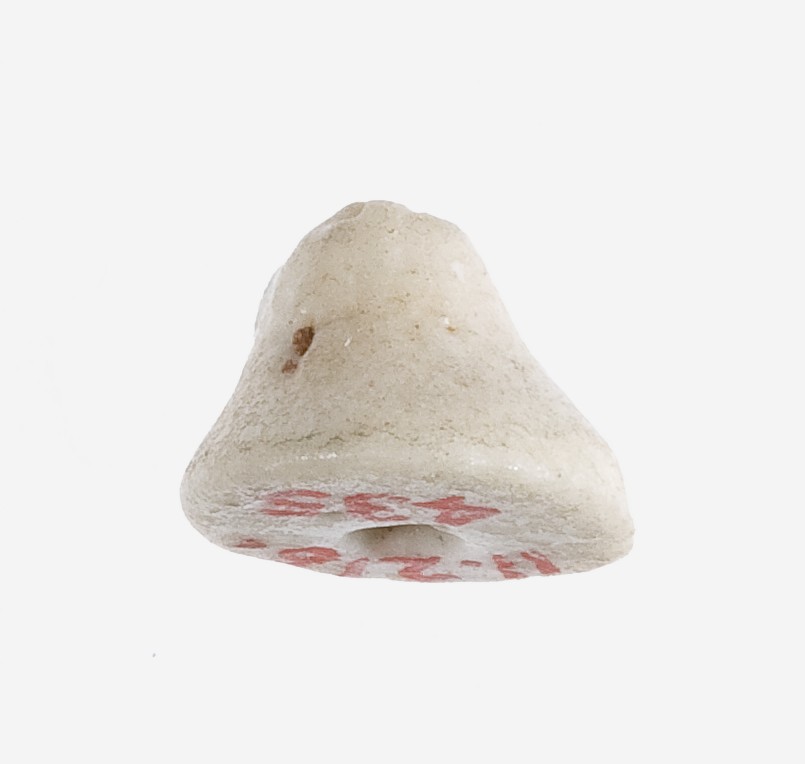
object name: pendant, umbel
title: Umbel Pendant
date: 1390-1352 BCE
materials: faience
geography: egypt